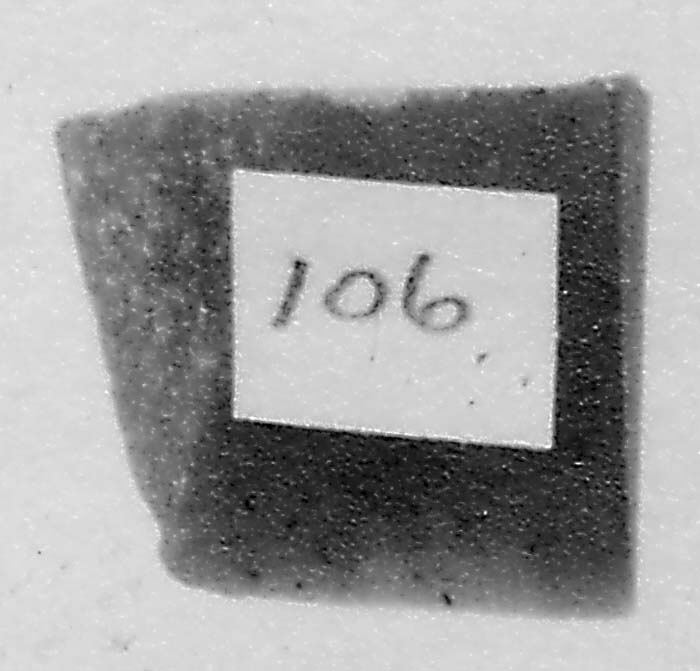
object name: fragment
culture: russian, siberia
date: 1902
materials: jade